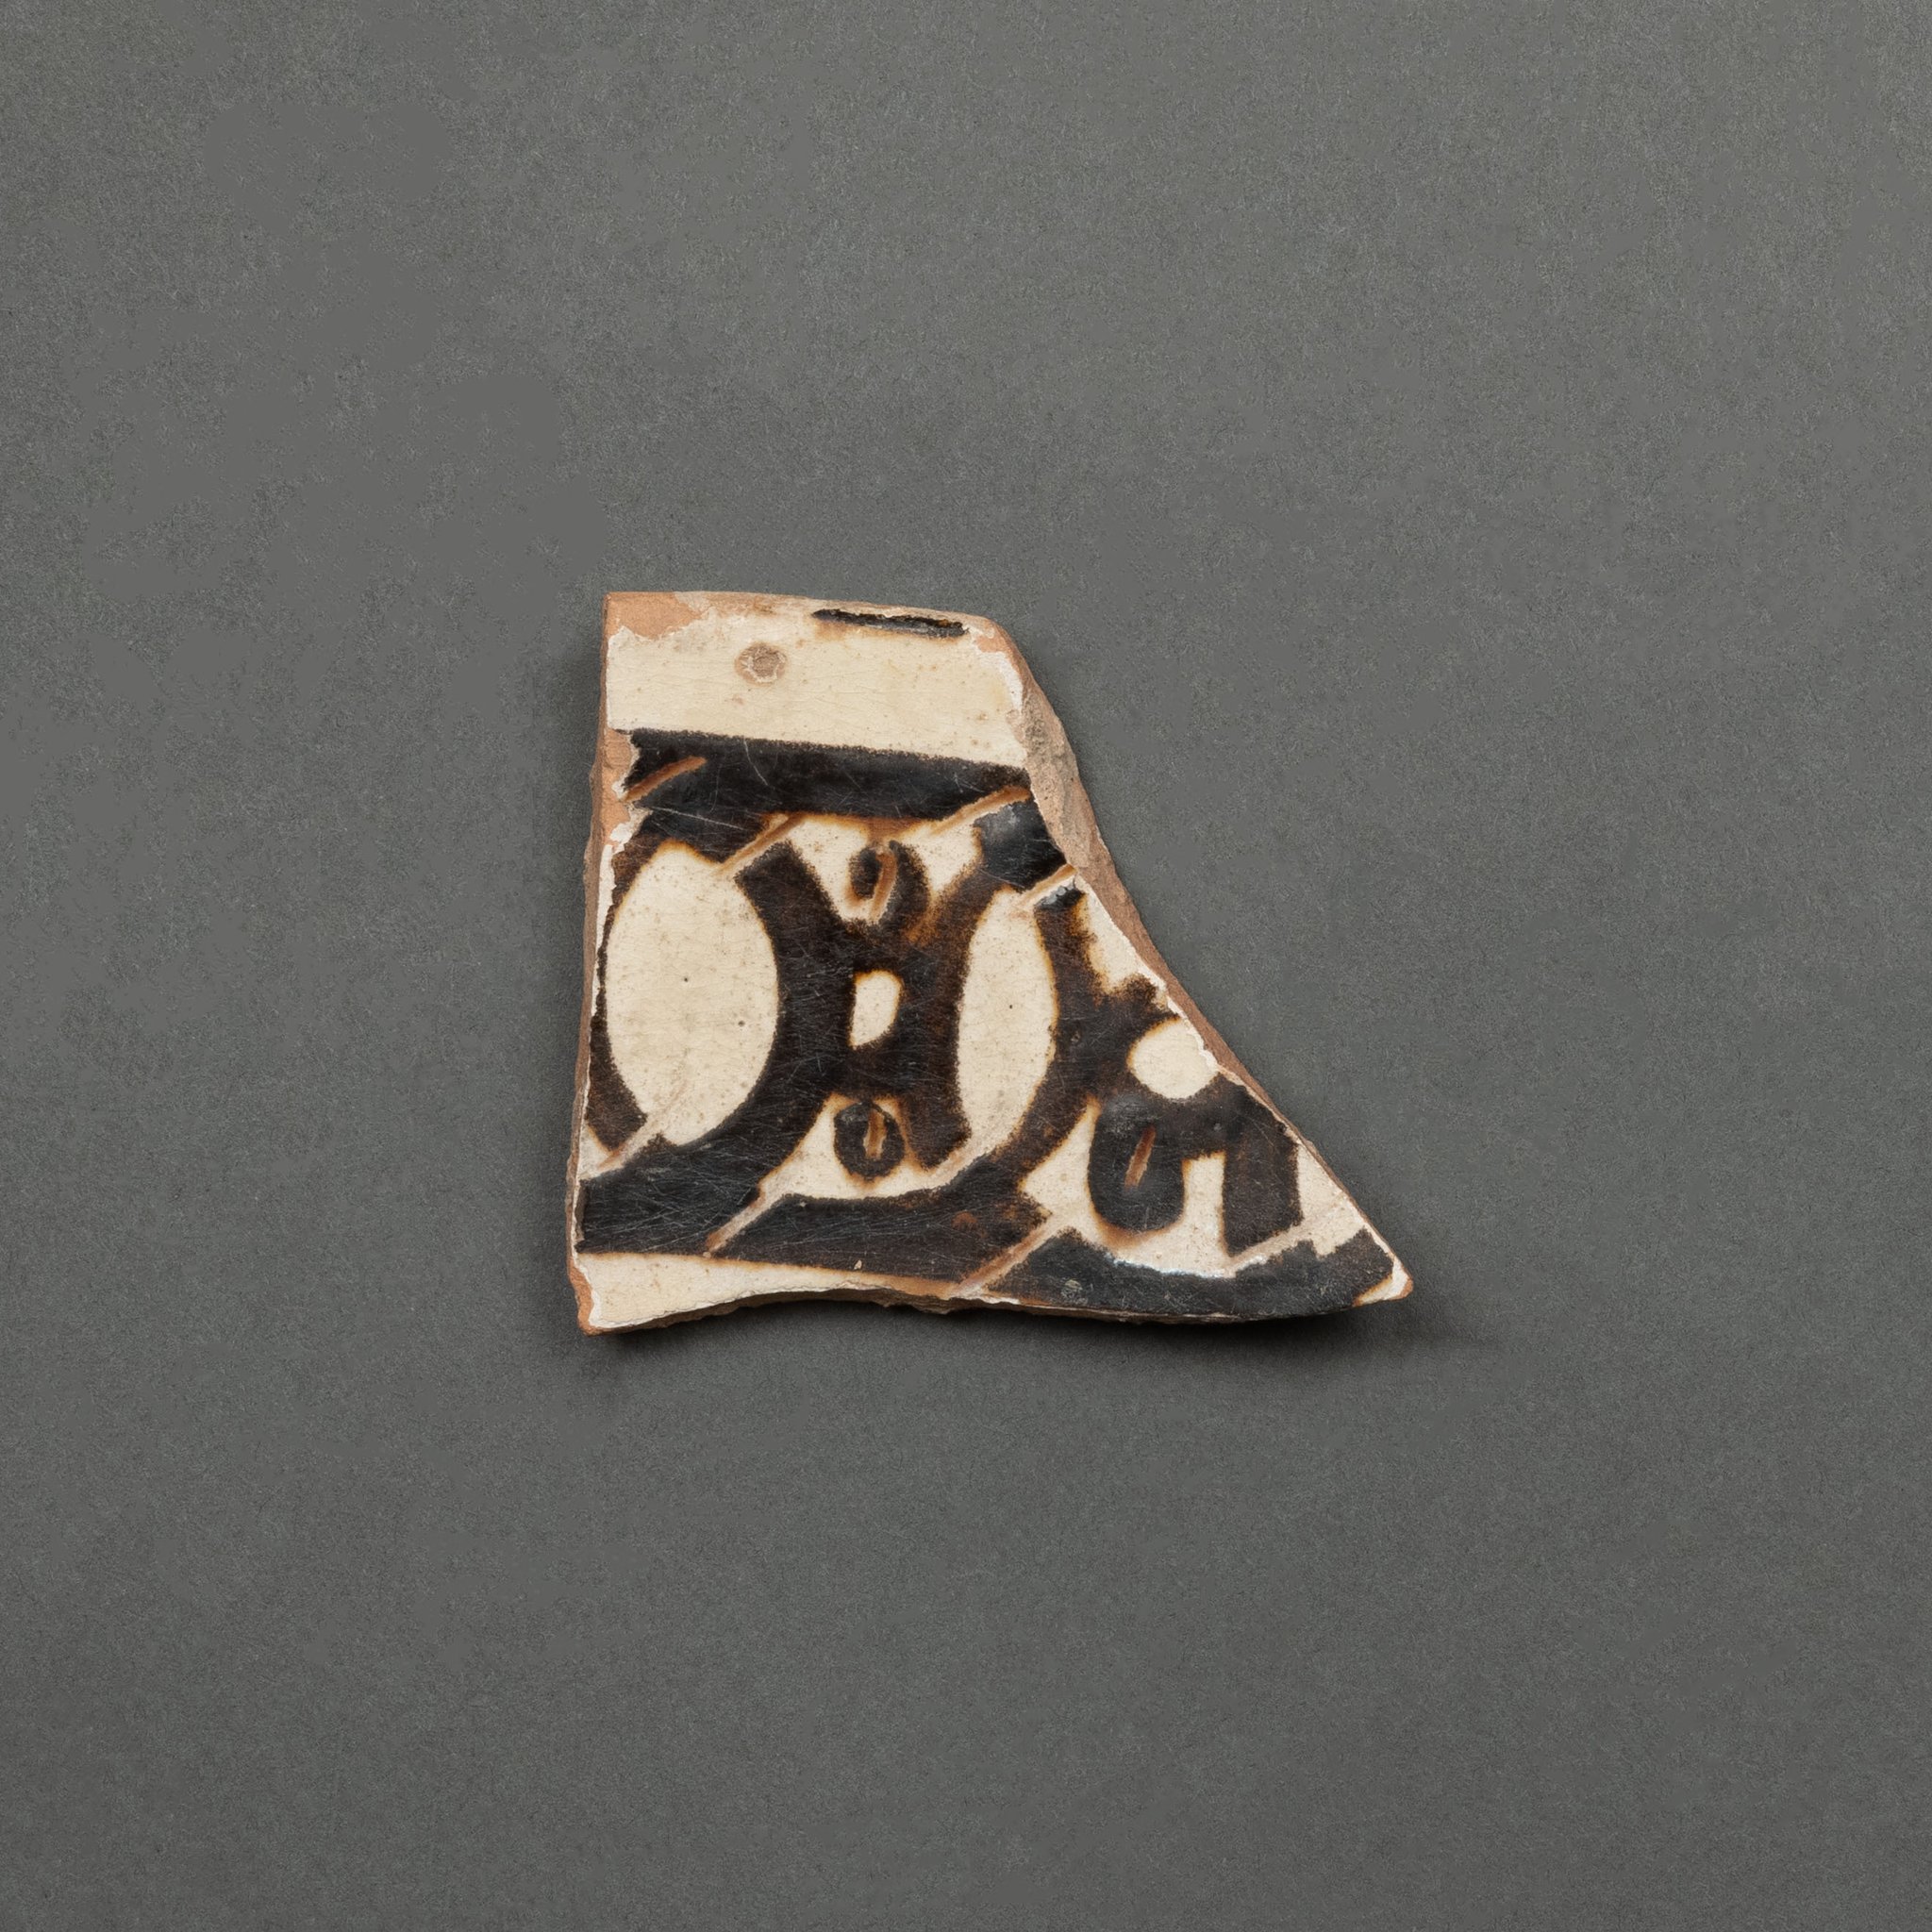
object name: fragment of a bowl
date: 801-1000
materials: earthenware, glaze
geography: iran